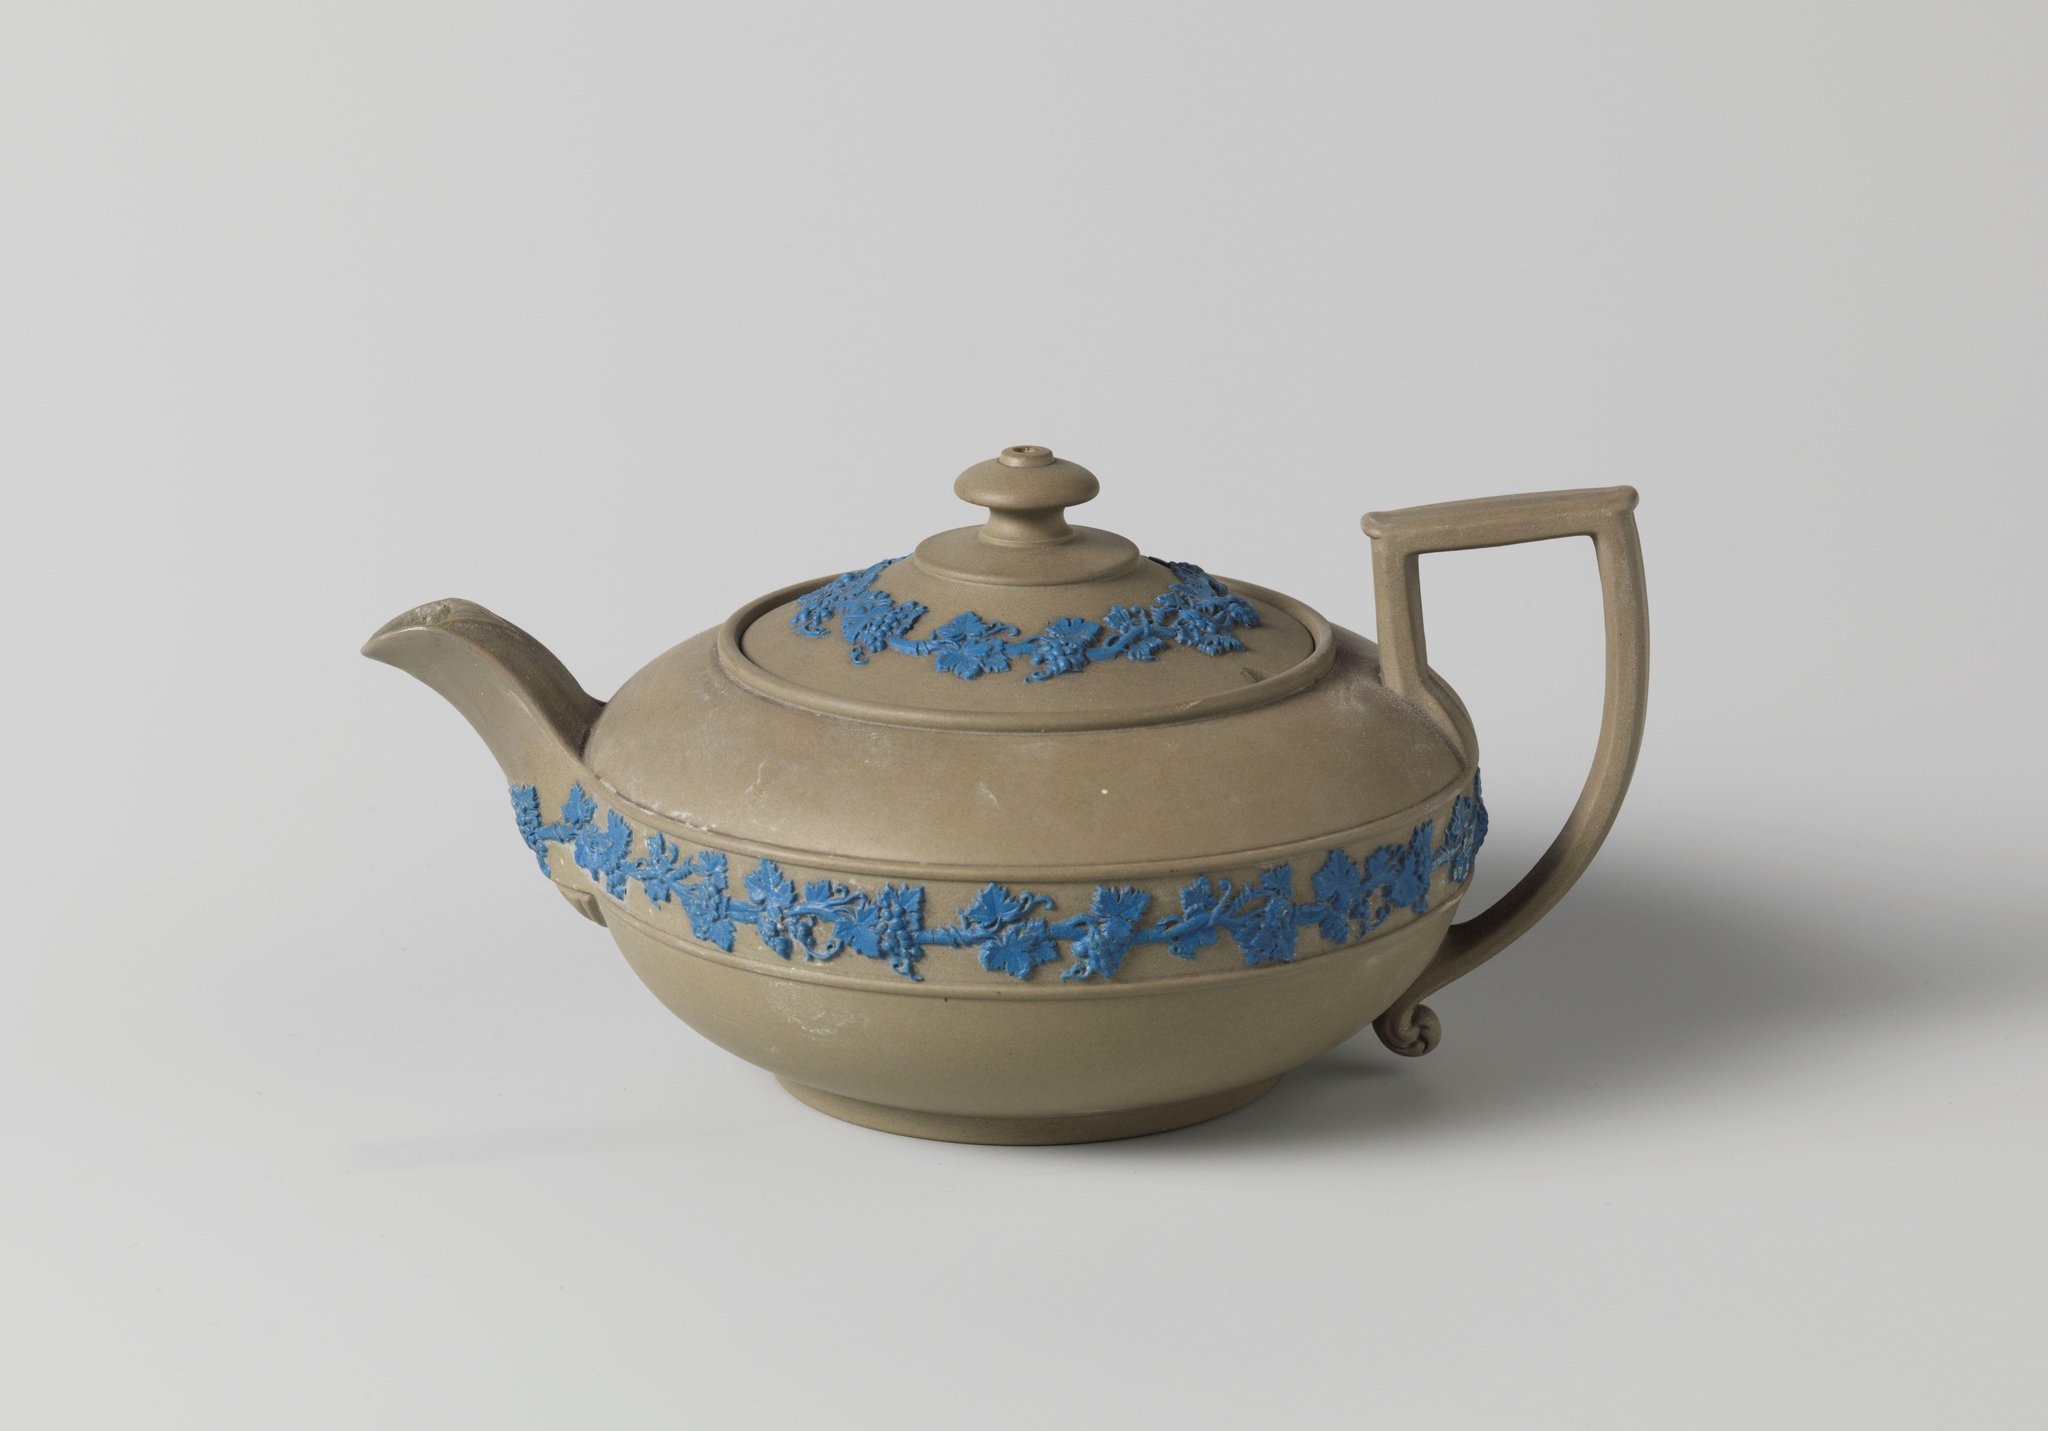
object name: pot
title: Theepot van hardgebakken aardewerk; Wedgwood.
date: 1790-1810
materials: earthenware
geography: england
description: Theepot van hardgebakken aardewerk. De buik heeft de vorm van een liggende ellipsch. De pot heeft een gebogen tuit, een hoekig oor . De buik is versierd met een blauwe rand van druiventrossen en wijnranken in reliëf. Bij de theepot hoort een suikerpot (BK-15430-B), een melkkan (BK-15430-C) en een spoelkom (BK-15430-D). De theepot is gemerkt.